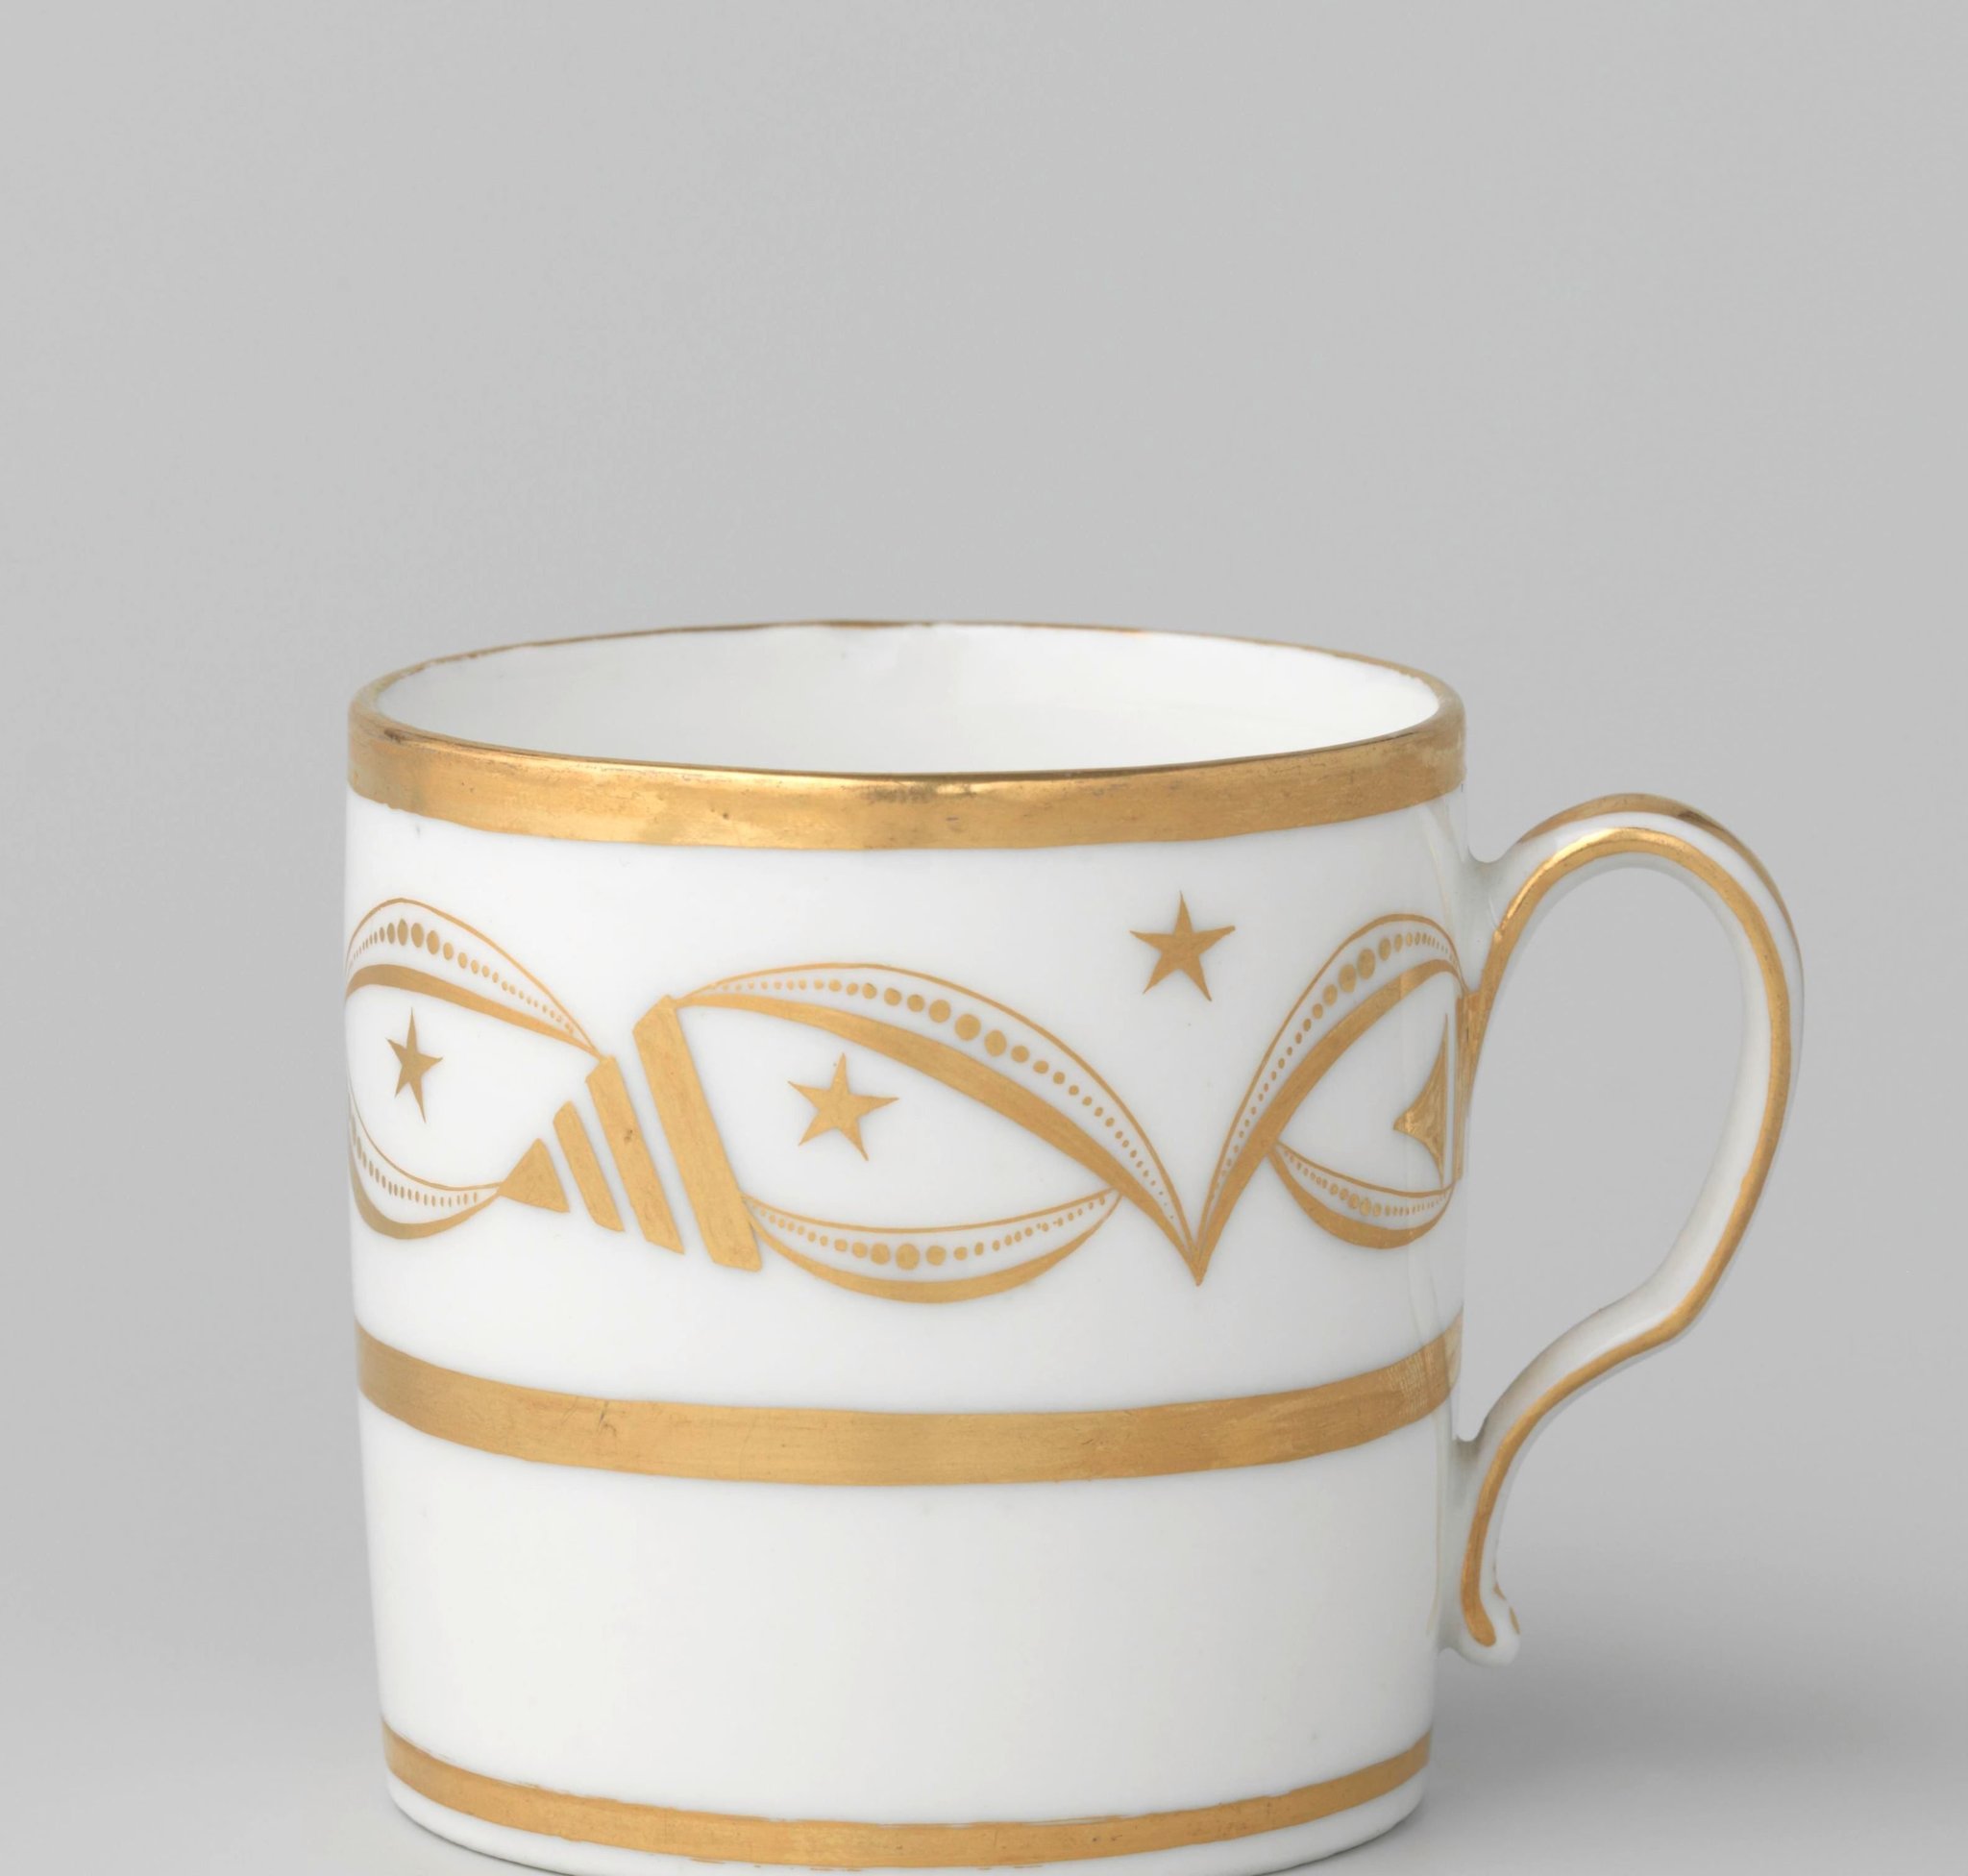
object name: service set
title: Cup with an ornamental border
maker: Anonymous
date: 1800-1824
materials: glaze, gold, paint, porcelain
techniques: firing, forming, gilding, turning, vitrification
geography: france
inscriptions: mark: ‘C’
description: Kop van porselein, recht model met oor, versierd met gouden banden waartussen een slingermotief dat wordt gevormd door halvemaanvormige schijven waarin punten. De schijven worden verbonden door driehoeken. Op de tussenliggende velden gouden sterren. Behoort tot een serie van twaalf kop-en-schotels (F-1-24), onderdeel van een koffie- en theeservies. Opmerking: van één kop is het oor afgebroken.